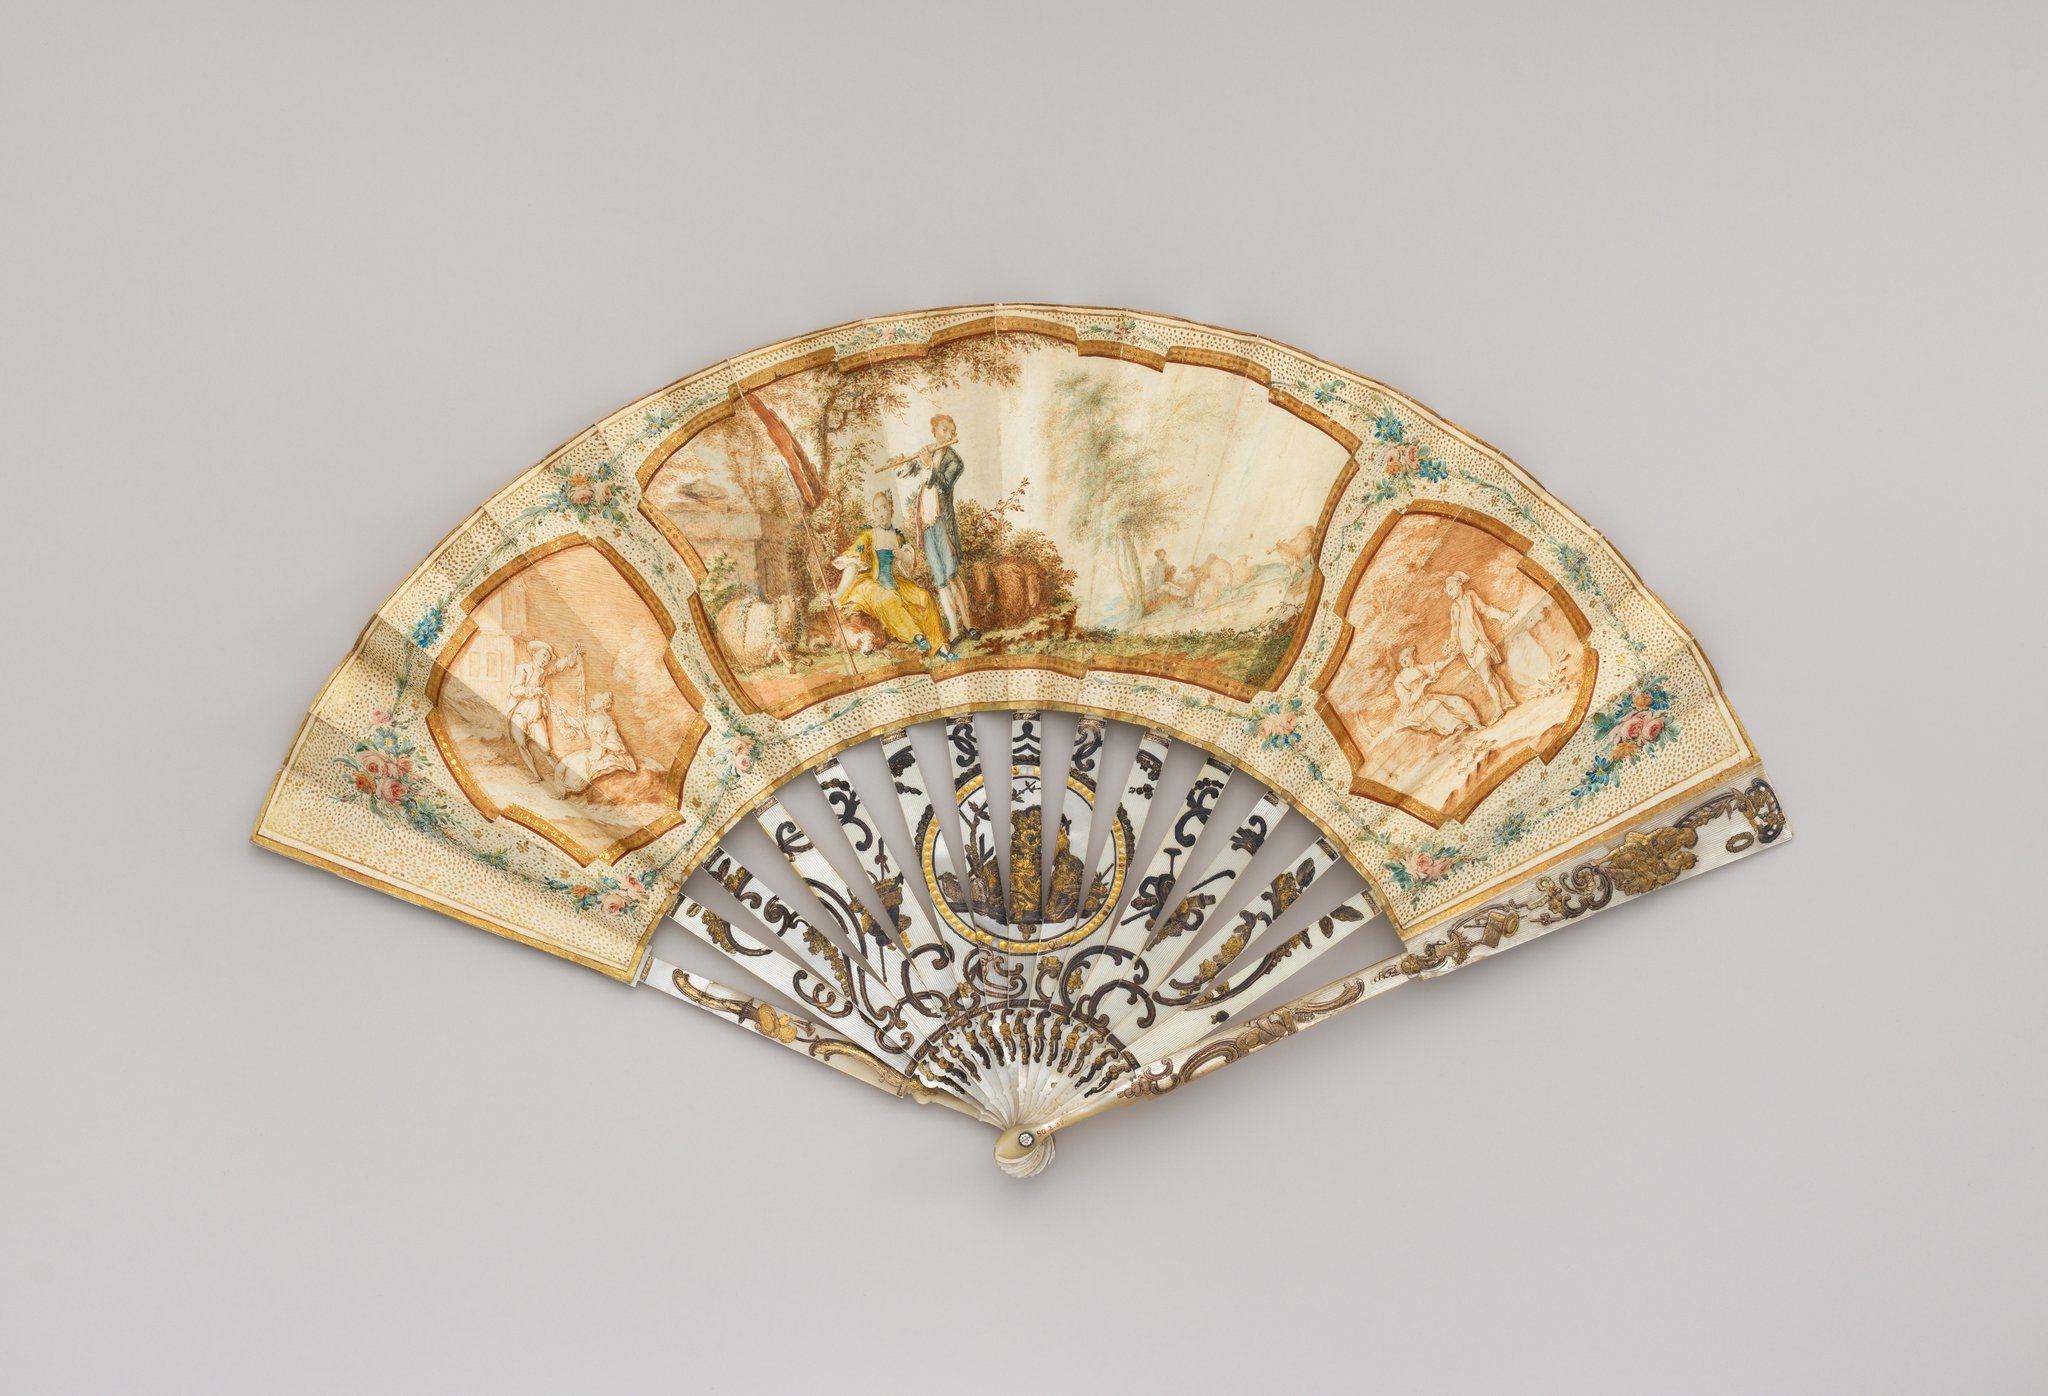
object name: fan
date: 1770-1790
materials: gold, mother of pearl, paint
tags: men,women,flutes,sheep